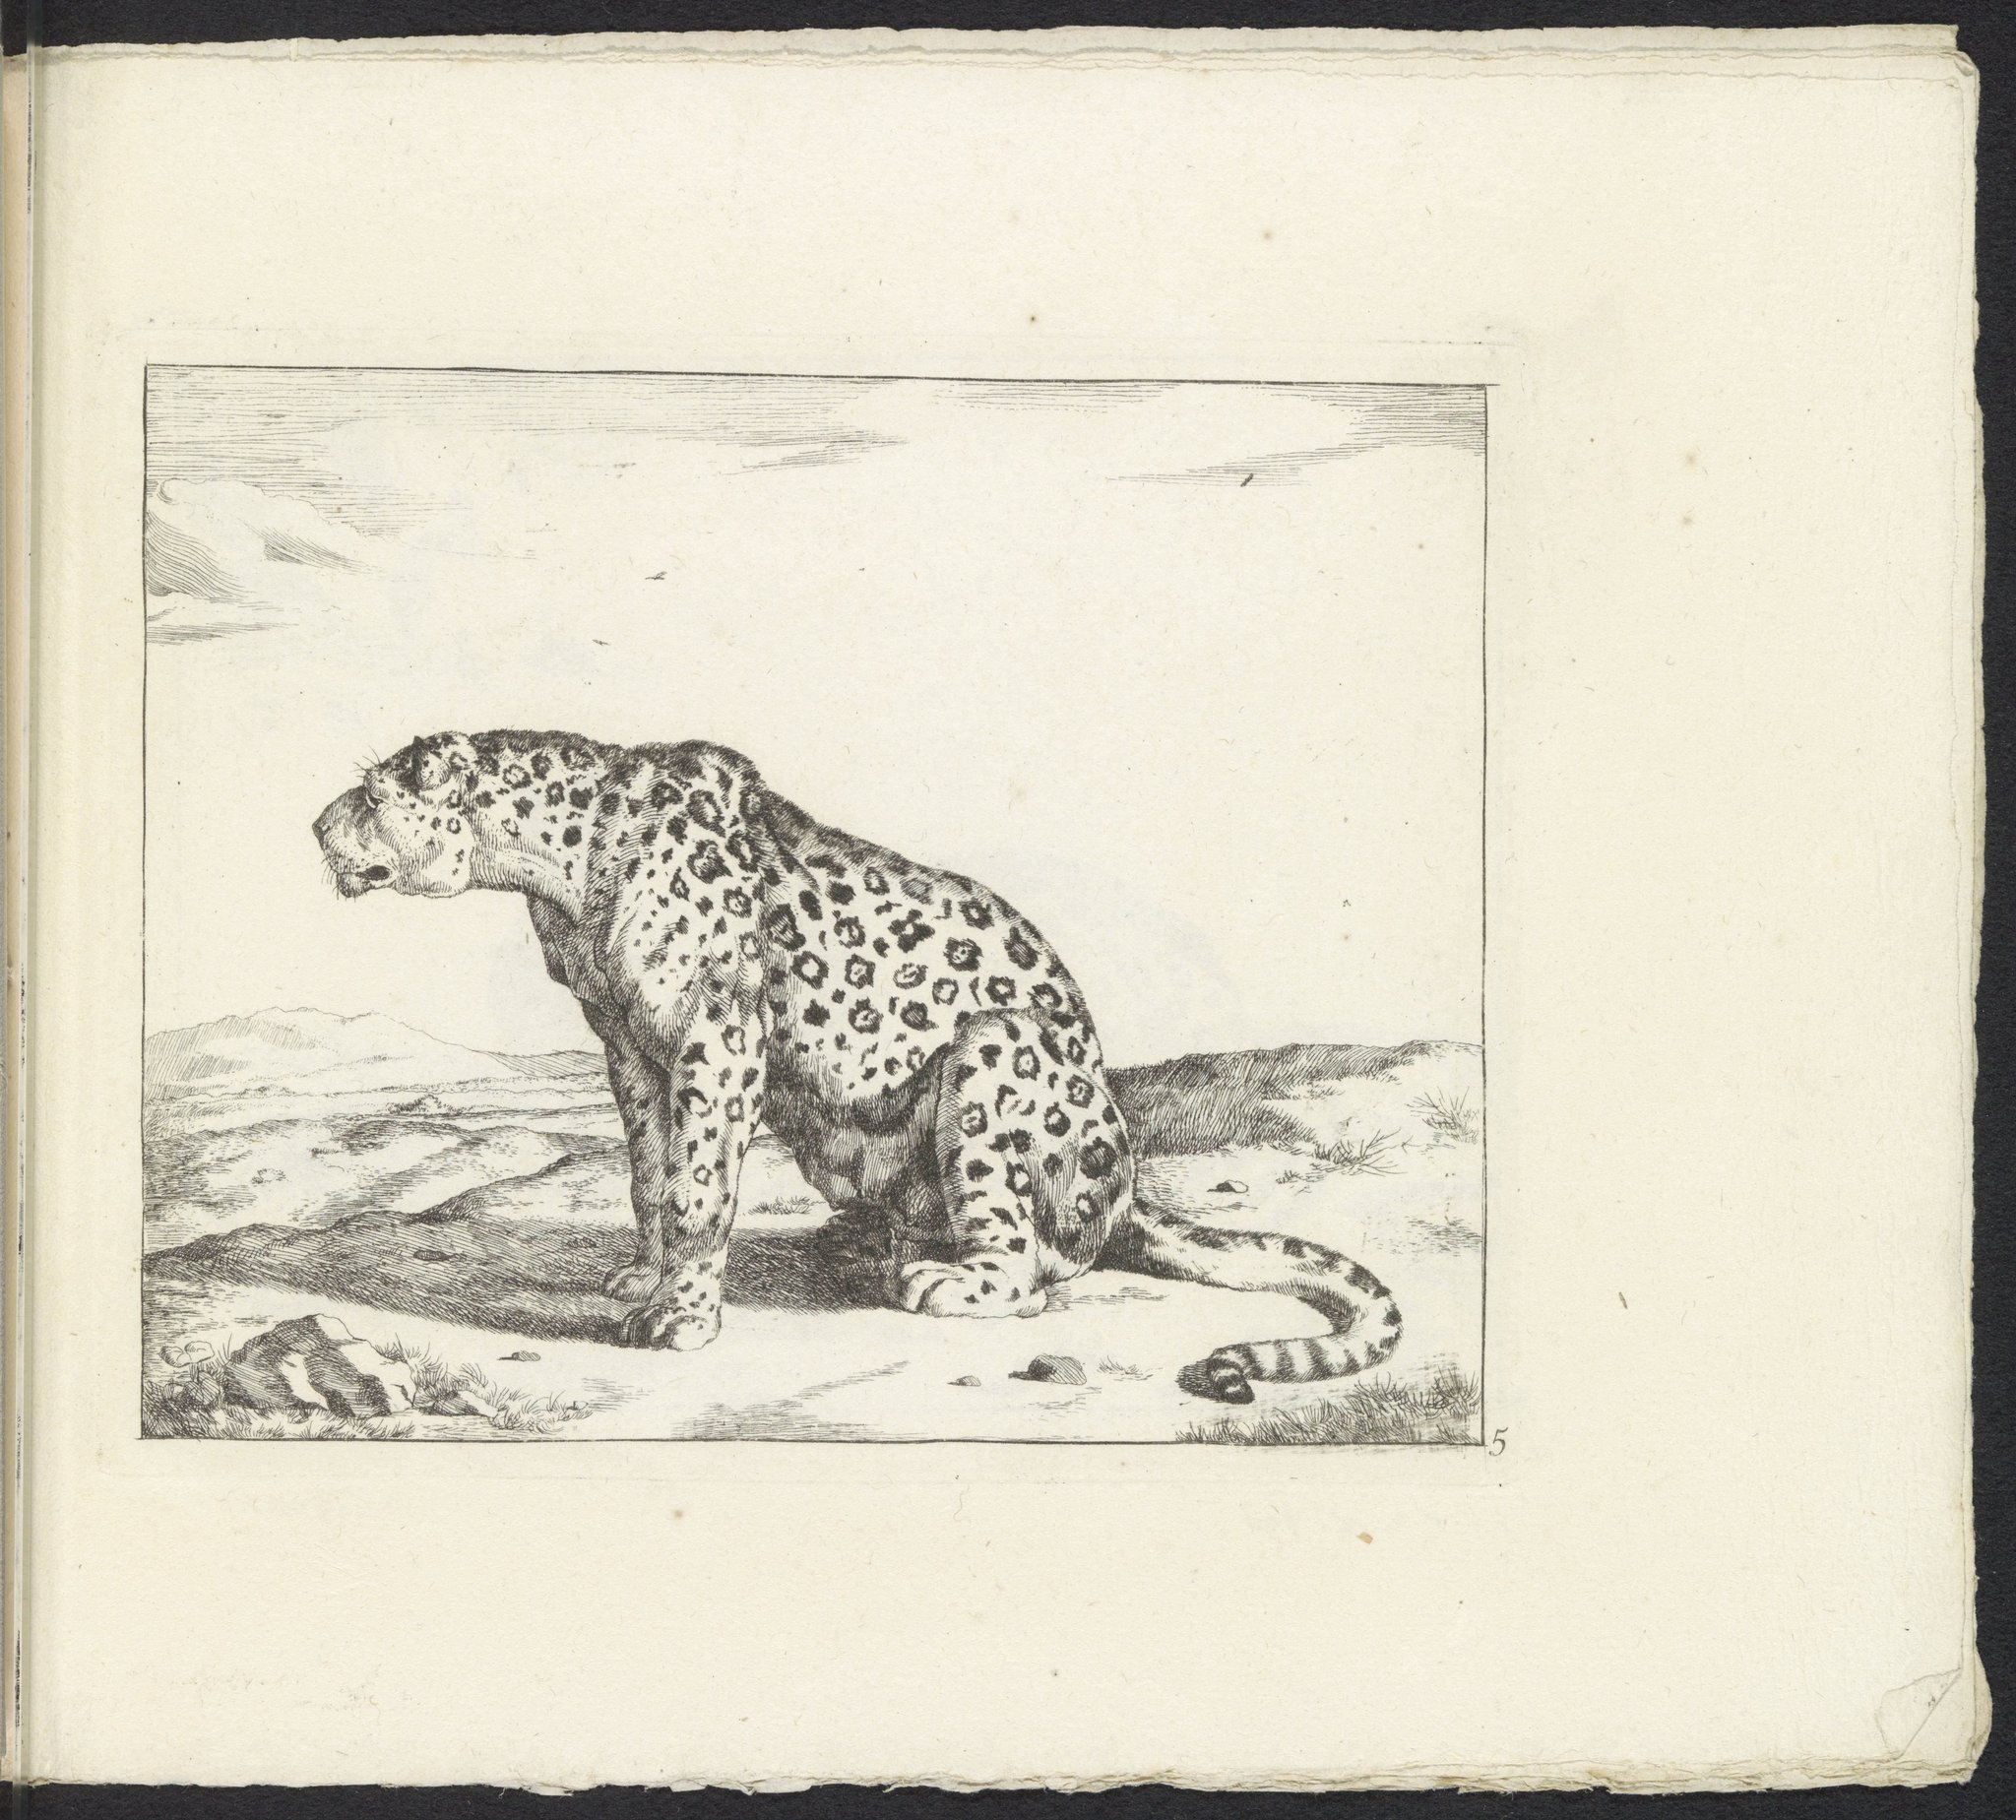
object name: print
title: Luipaard zittend op achterpoten, naar links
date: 1657-1677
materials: paper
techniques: etching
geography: amsterdam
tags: beasts of prey, predatory animals: leopard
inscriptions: collector's mark: Lugt 2228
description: Luipaard zittend op achterpoten, naar links. Prent uit een serie van acht genummerde prenten met ''naar het leven'' getekende luipaarden, de reeks aan bindtouw.